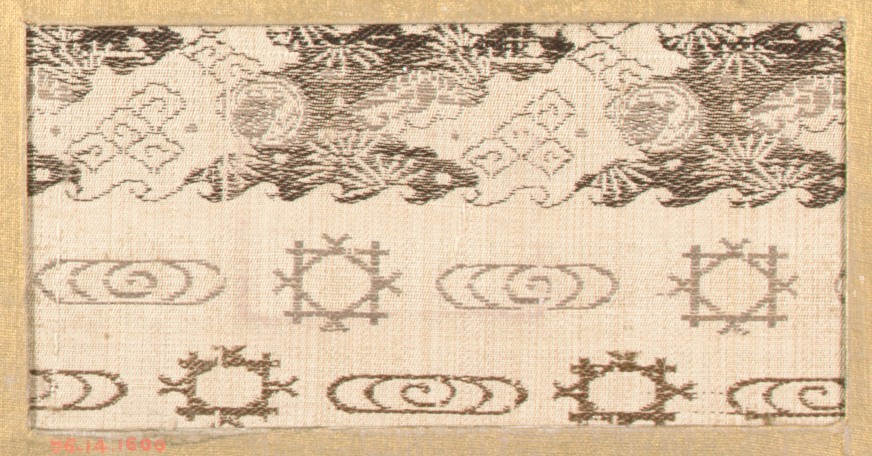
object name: piece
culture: japanese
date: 1701-1900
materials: silk